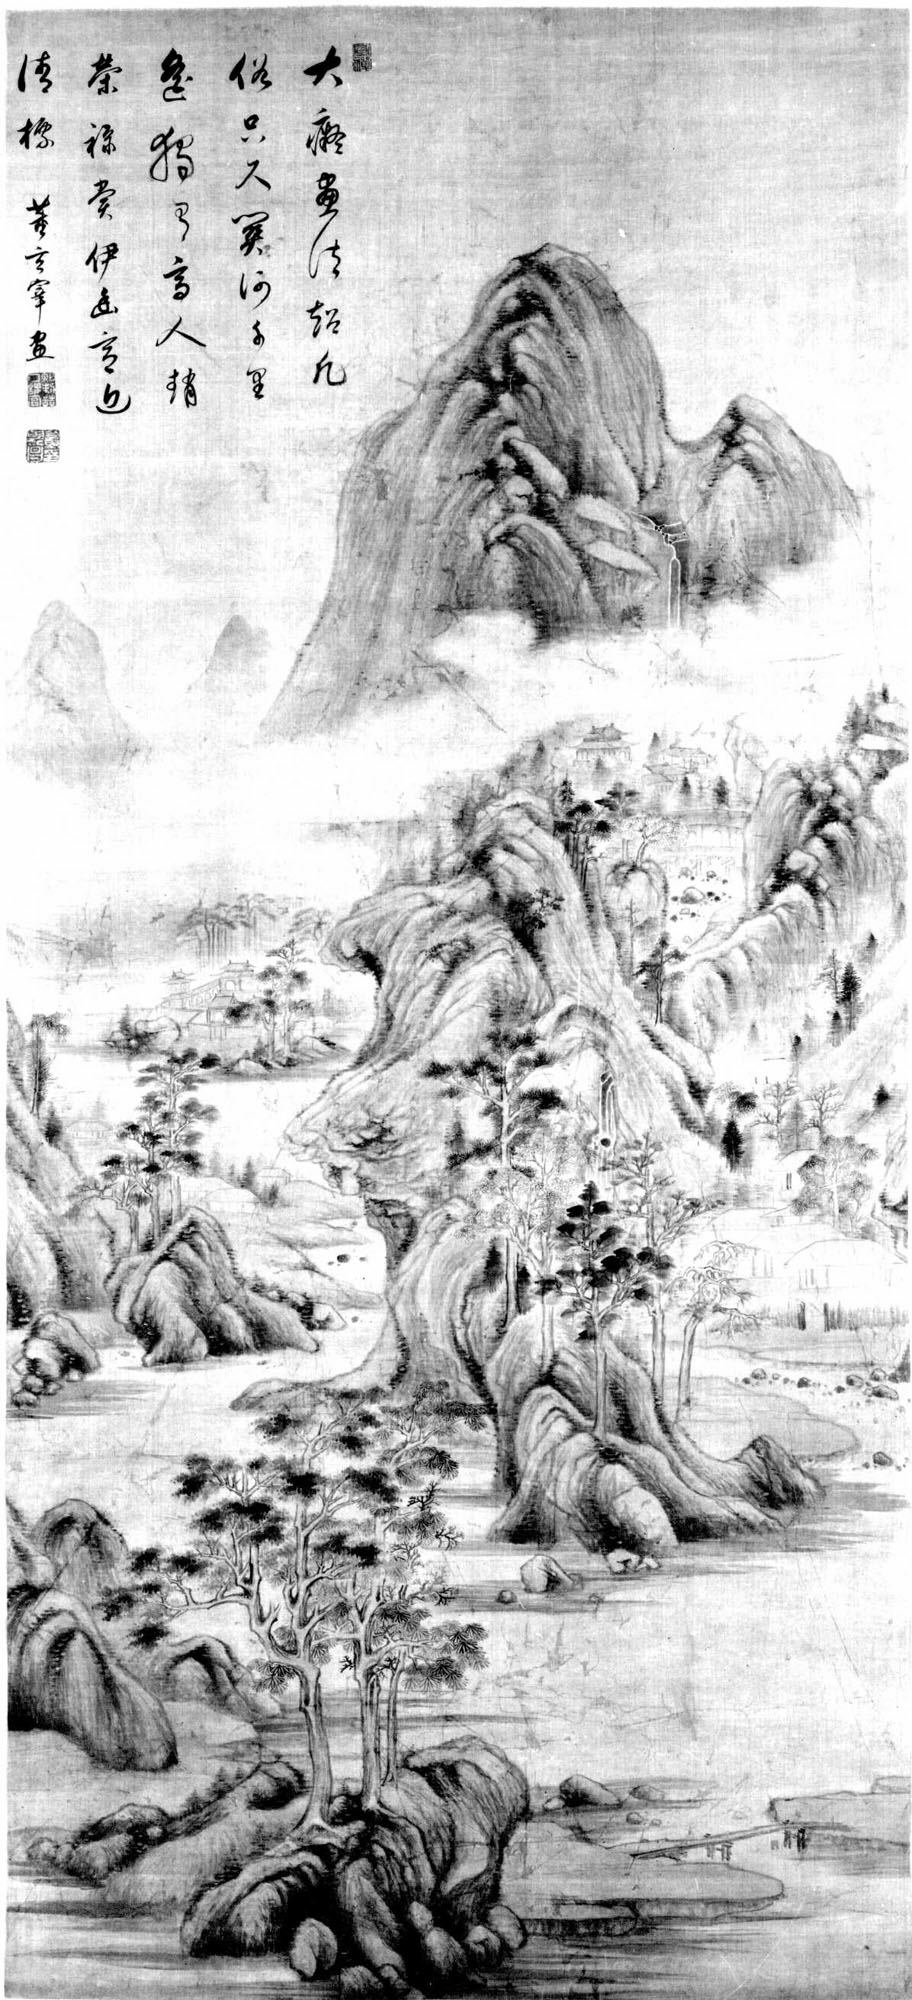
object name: hanging scroll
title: Landscape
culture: chinese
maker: zhao zuo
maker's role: artist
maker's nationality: chinese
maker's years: 1560-1630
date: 1630-1644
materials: ink, silk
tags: mountains,landscapes